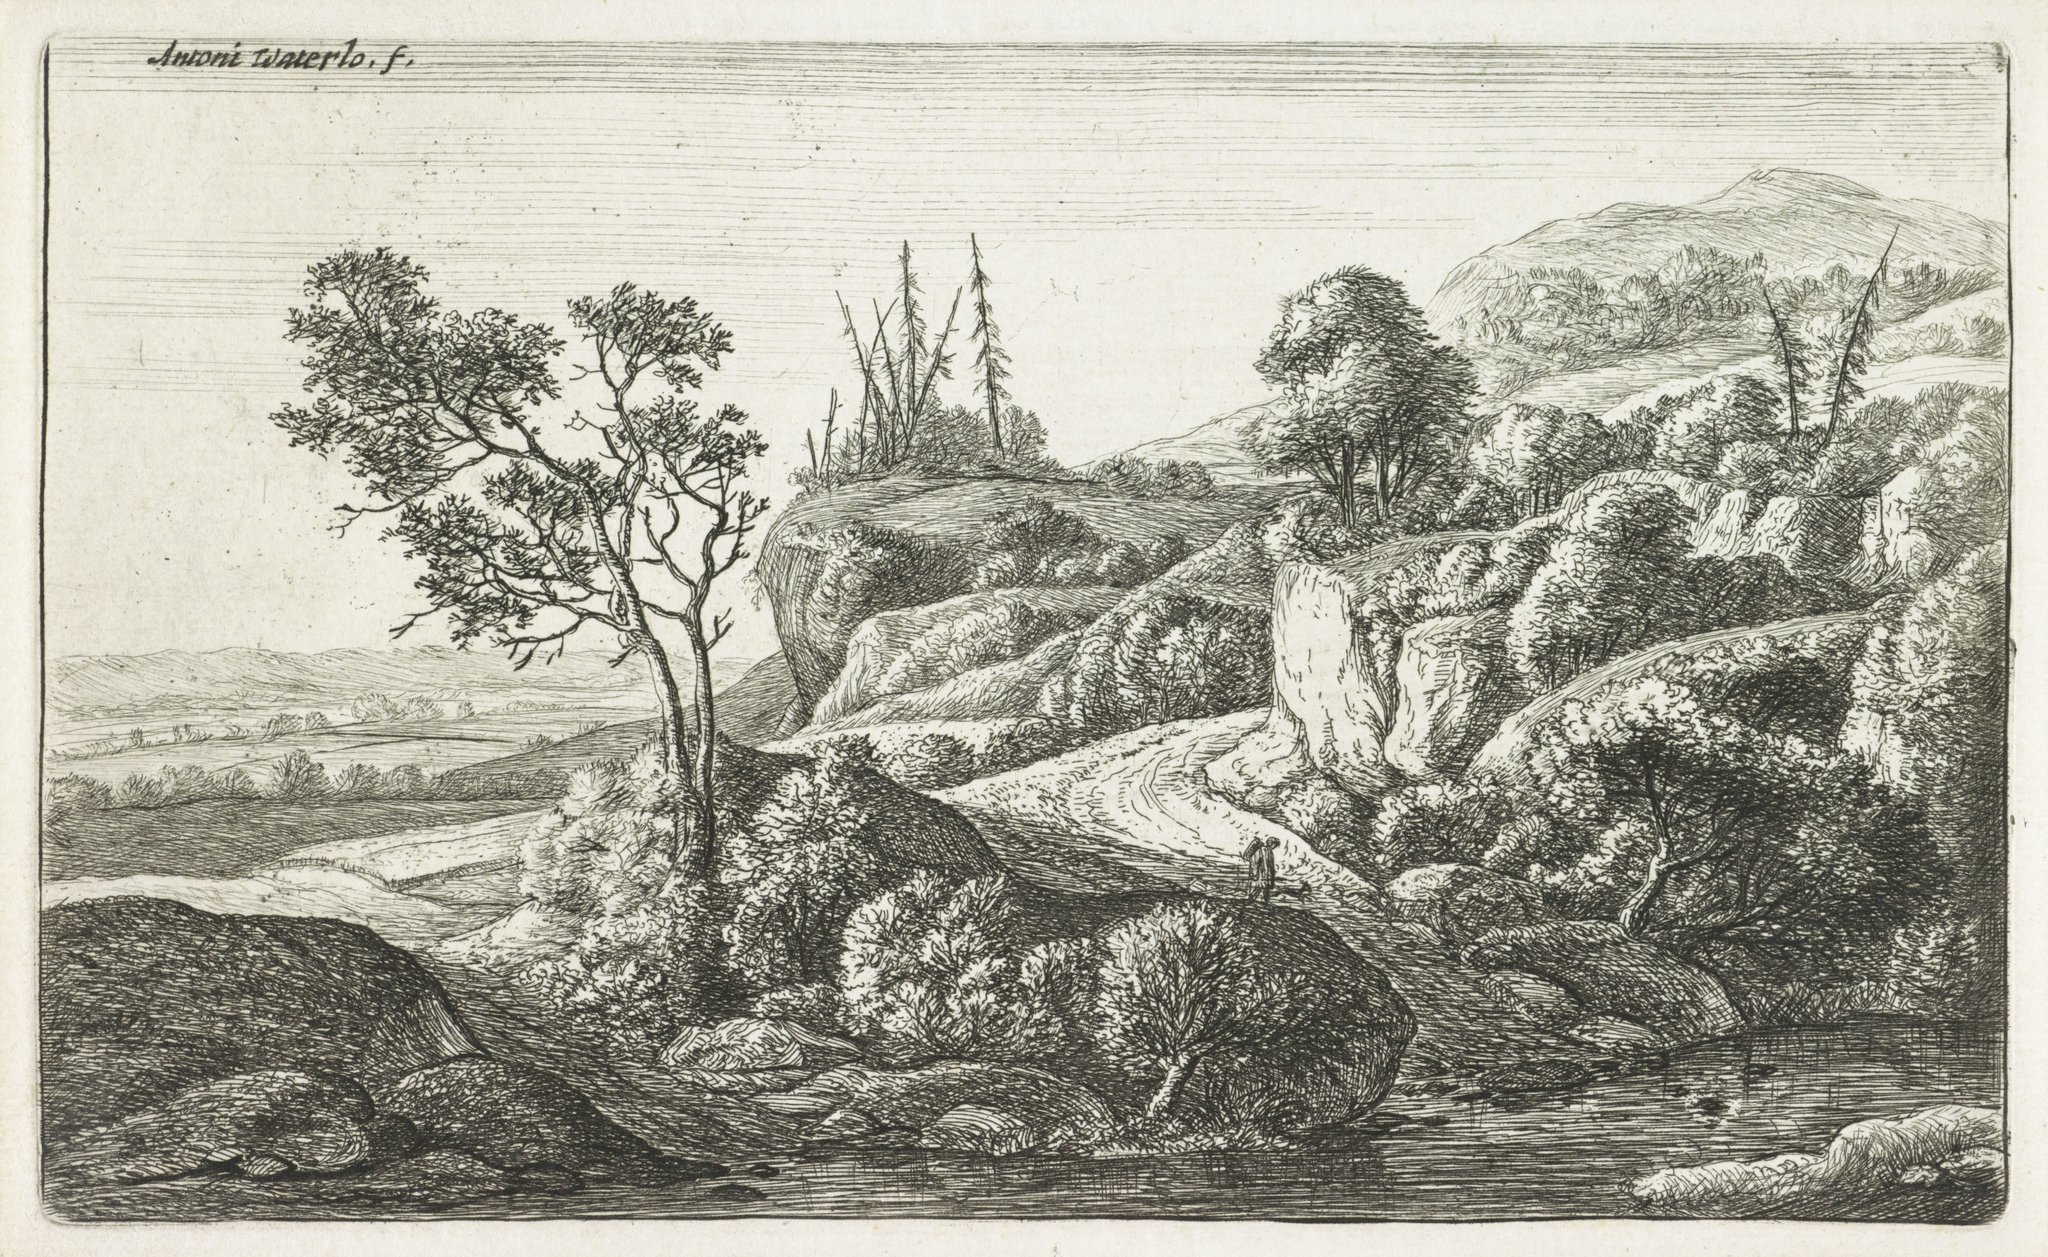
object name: print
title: Diverse landschappen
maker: anthonie waterloo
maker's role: draughtsman, painter, print maker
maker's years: 1609-1690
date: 1630-1663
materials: paper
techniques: etching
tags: road, path, brook, 'en route', traveller under way, mountains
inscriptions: collector's mark: Lugt 2233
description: Rechts loopt een pad over een met bomen en struiken begroeide berg. Het pad leidt naar een beek. Op de oever staat een figuur. Links in de verte is een glooiend landschap te zien.